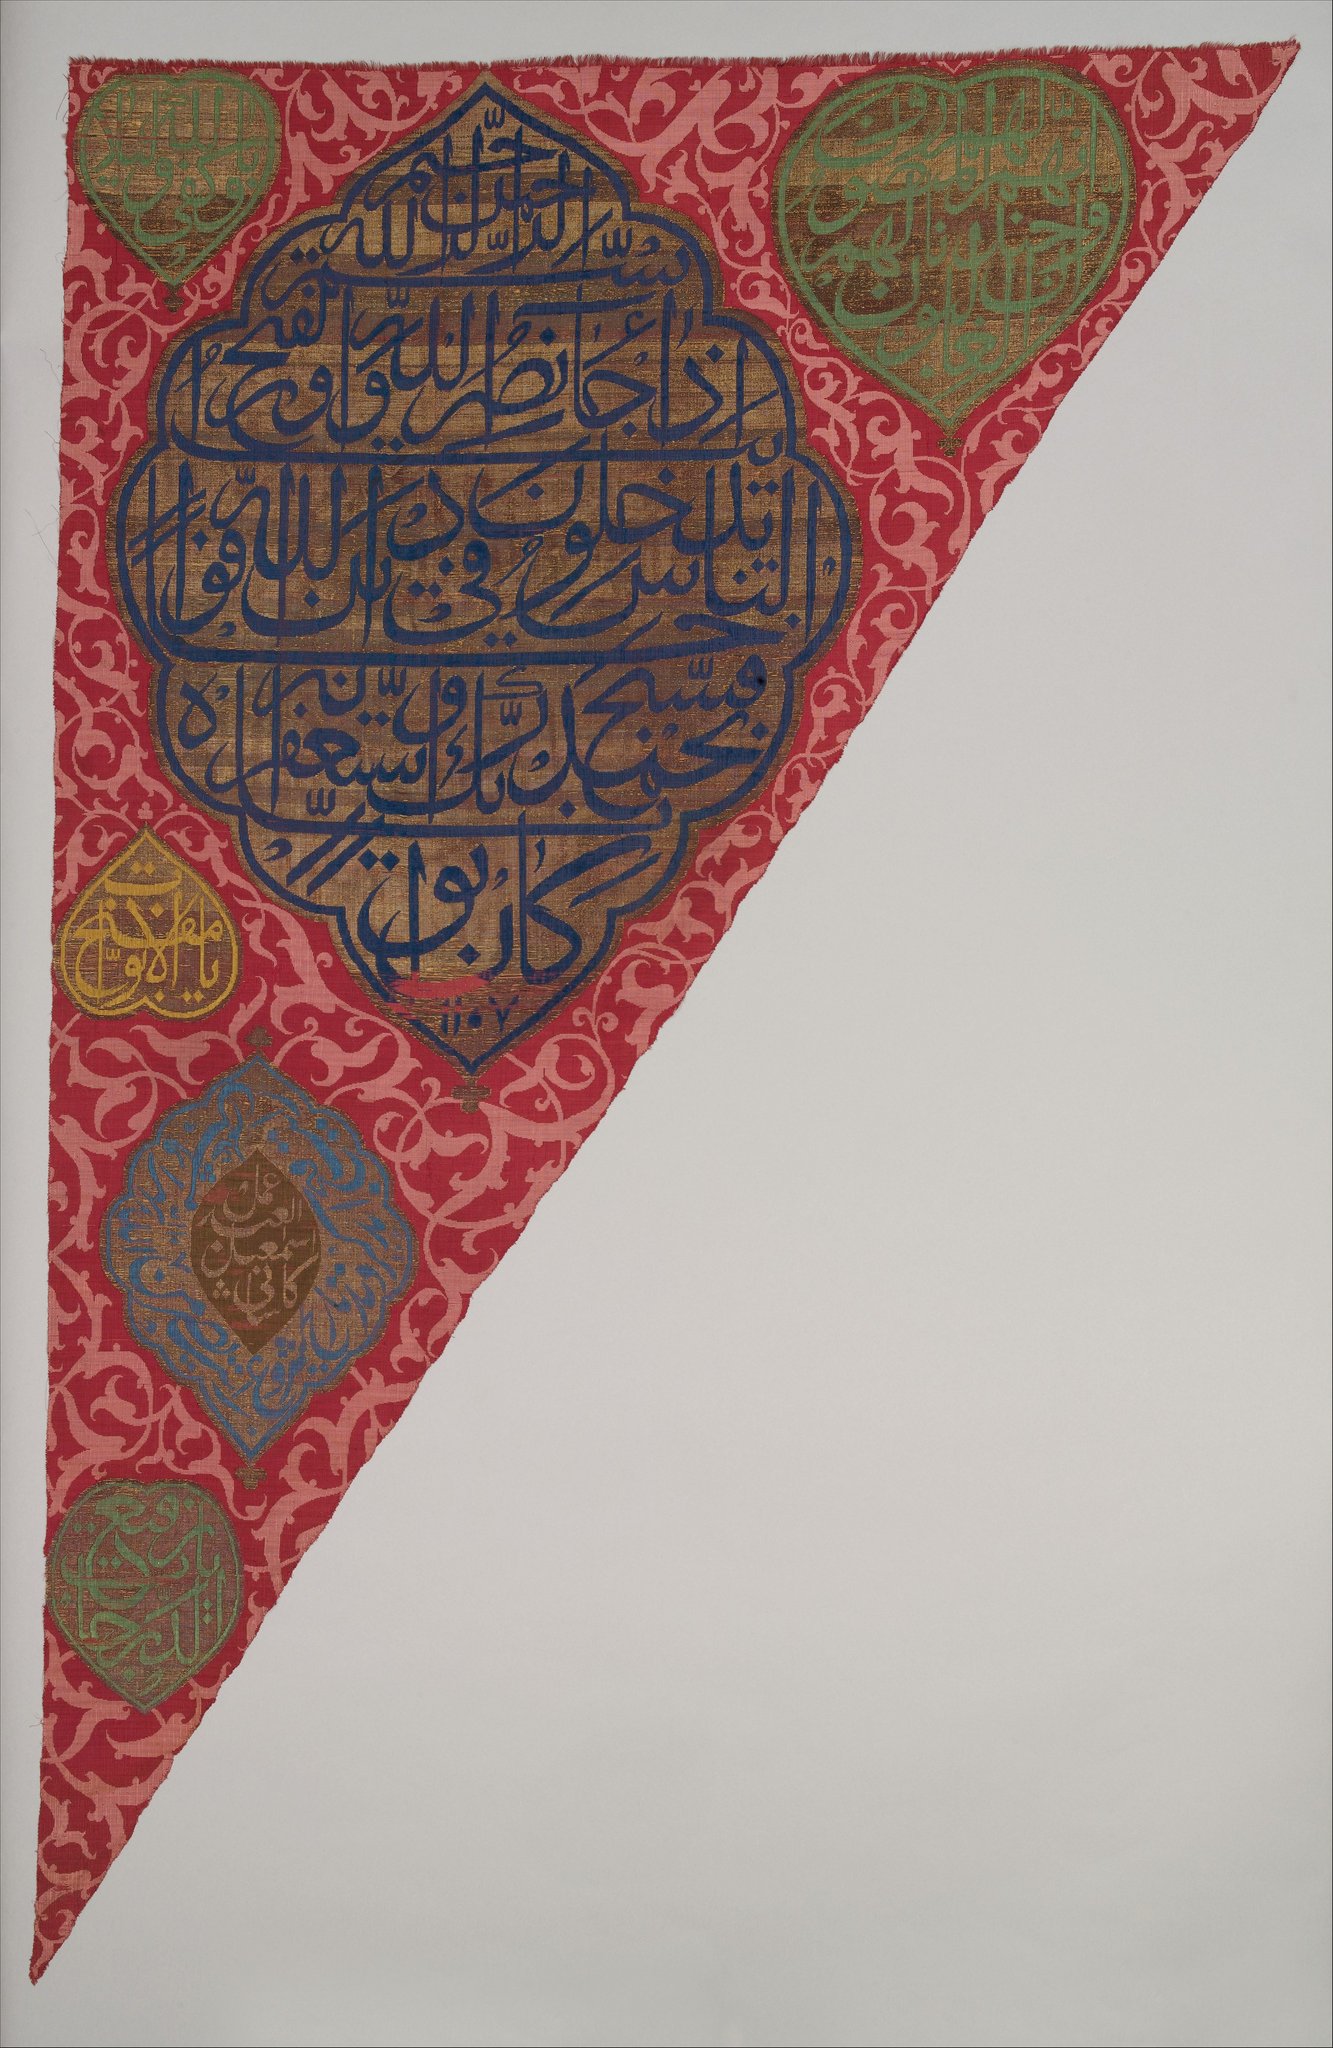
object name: banner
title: Inscribed Banner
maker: isma'il kashani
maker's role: maker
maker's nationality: iranian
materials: metal thread, silk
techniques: lampas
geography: iran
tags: arabic,persian,banners